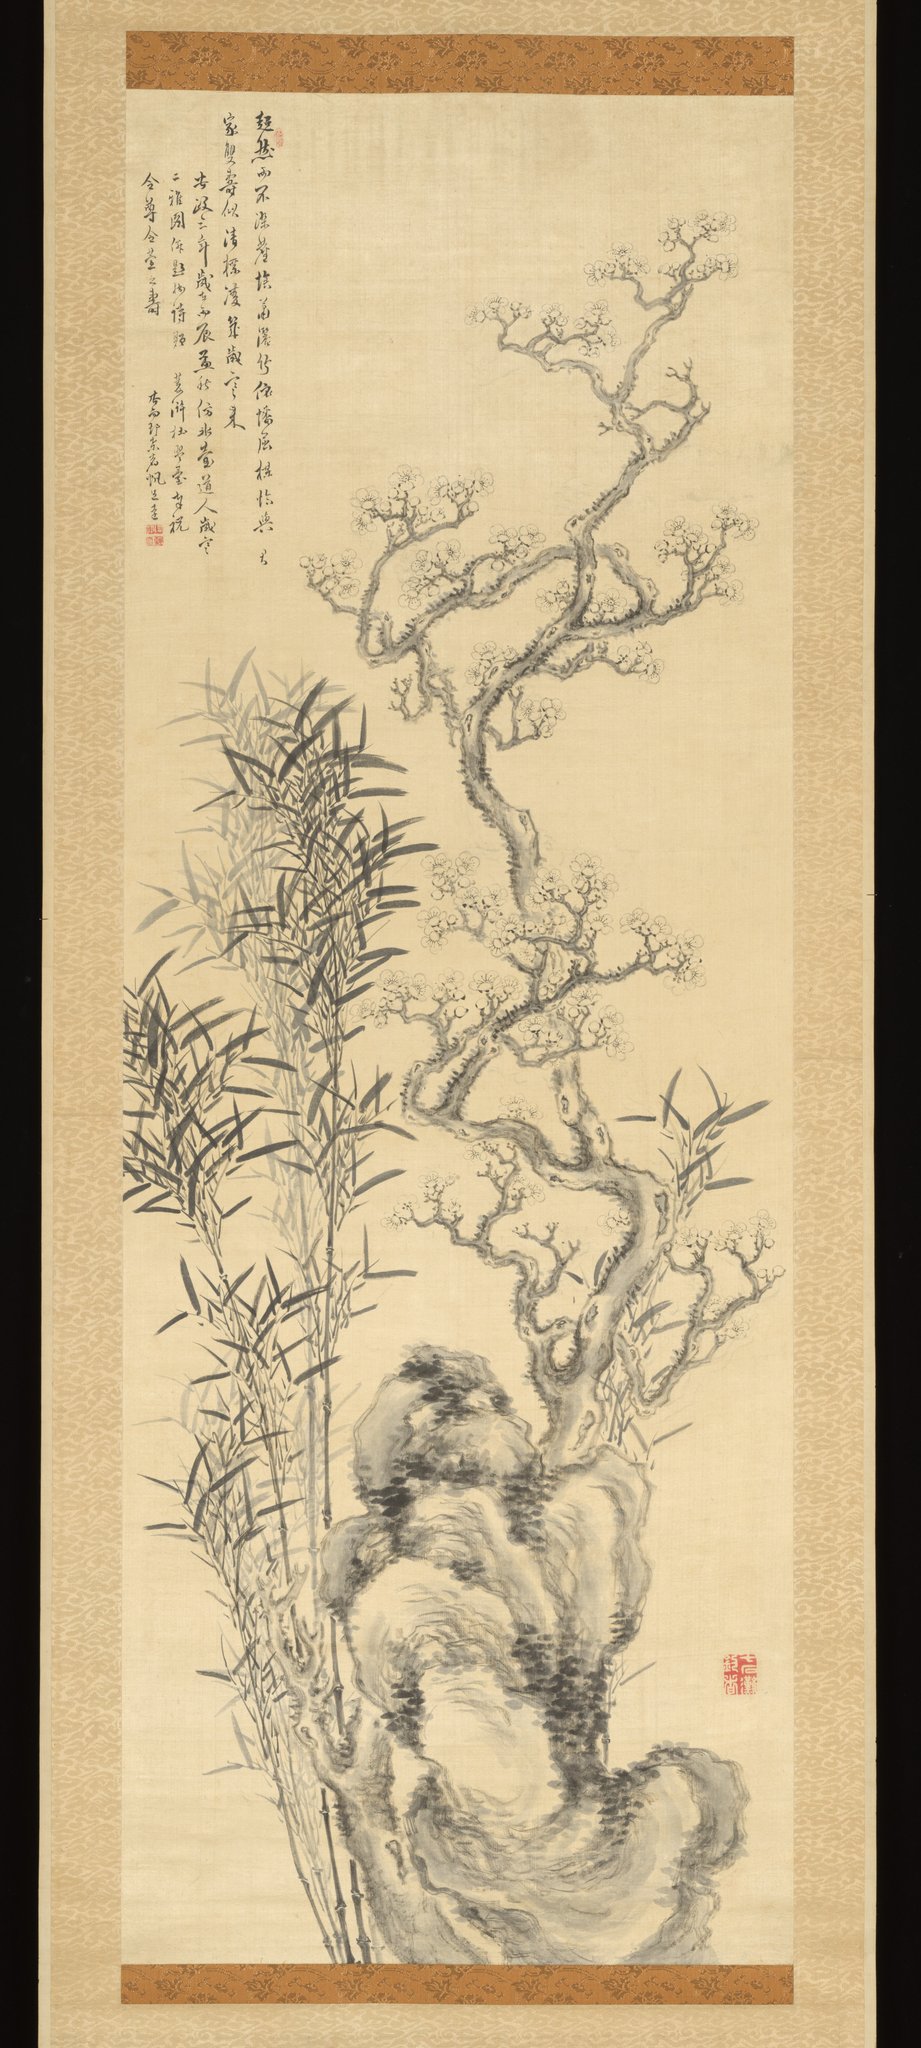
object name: hanging scroll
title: Ink Plum and Bamboo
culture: japanese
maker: hoashi kyōu 帆足杏雨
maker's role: artist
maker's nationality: japanese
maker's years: 1810-1884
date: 1856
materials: ink, textile